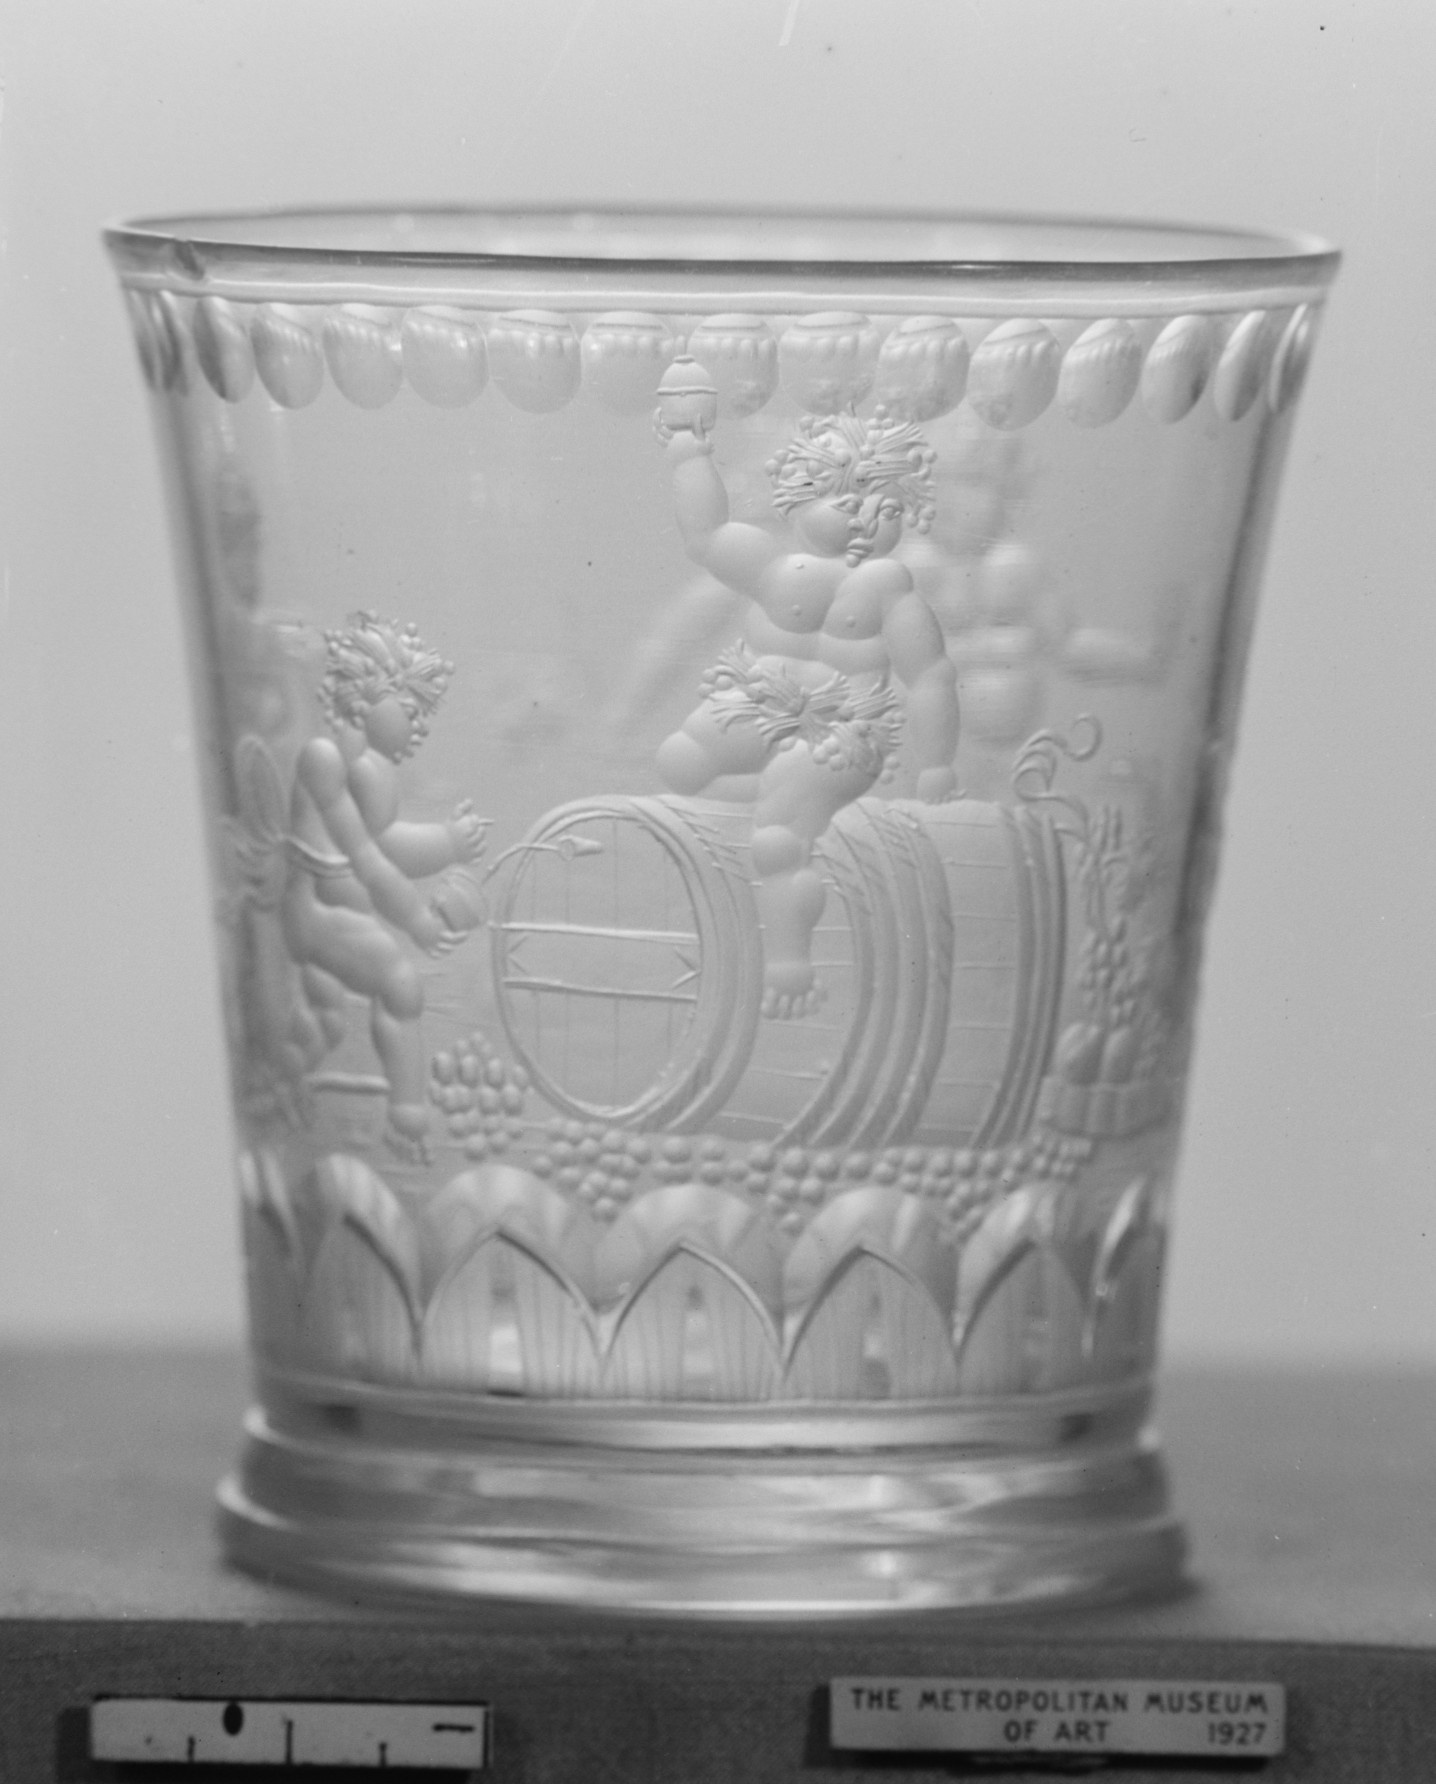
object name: beaker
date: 1701-1733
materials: glass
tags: putti